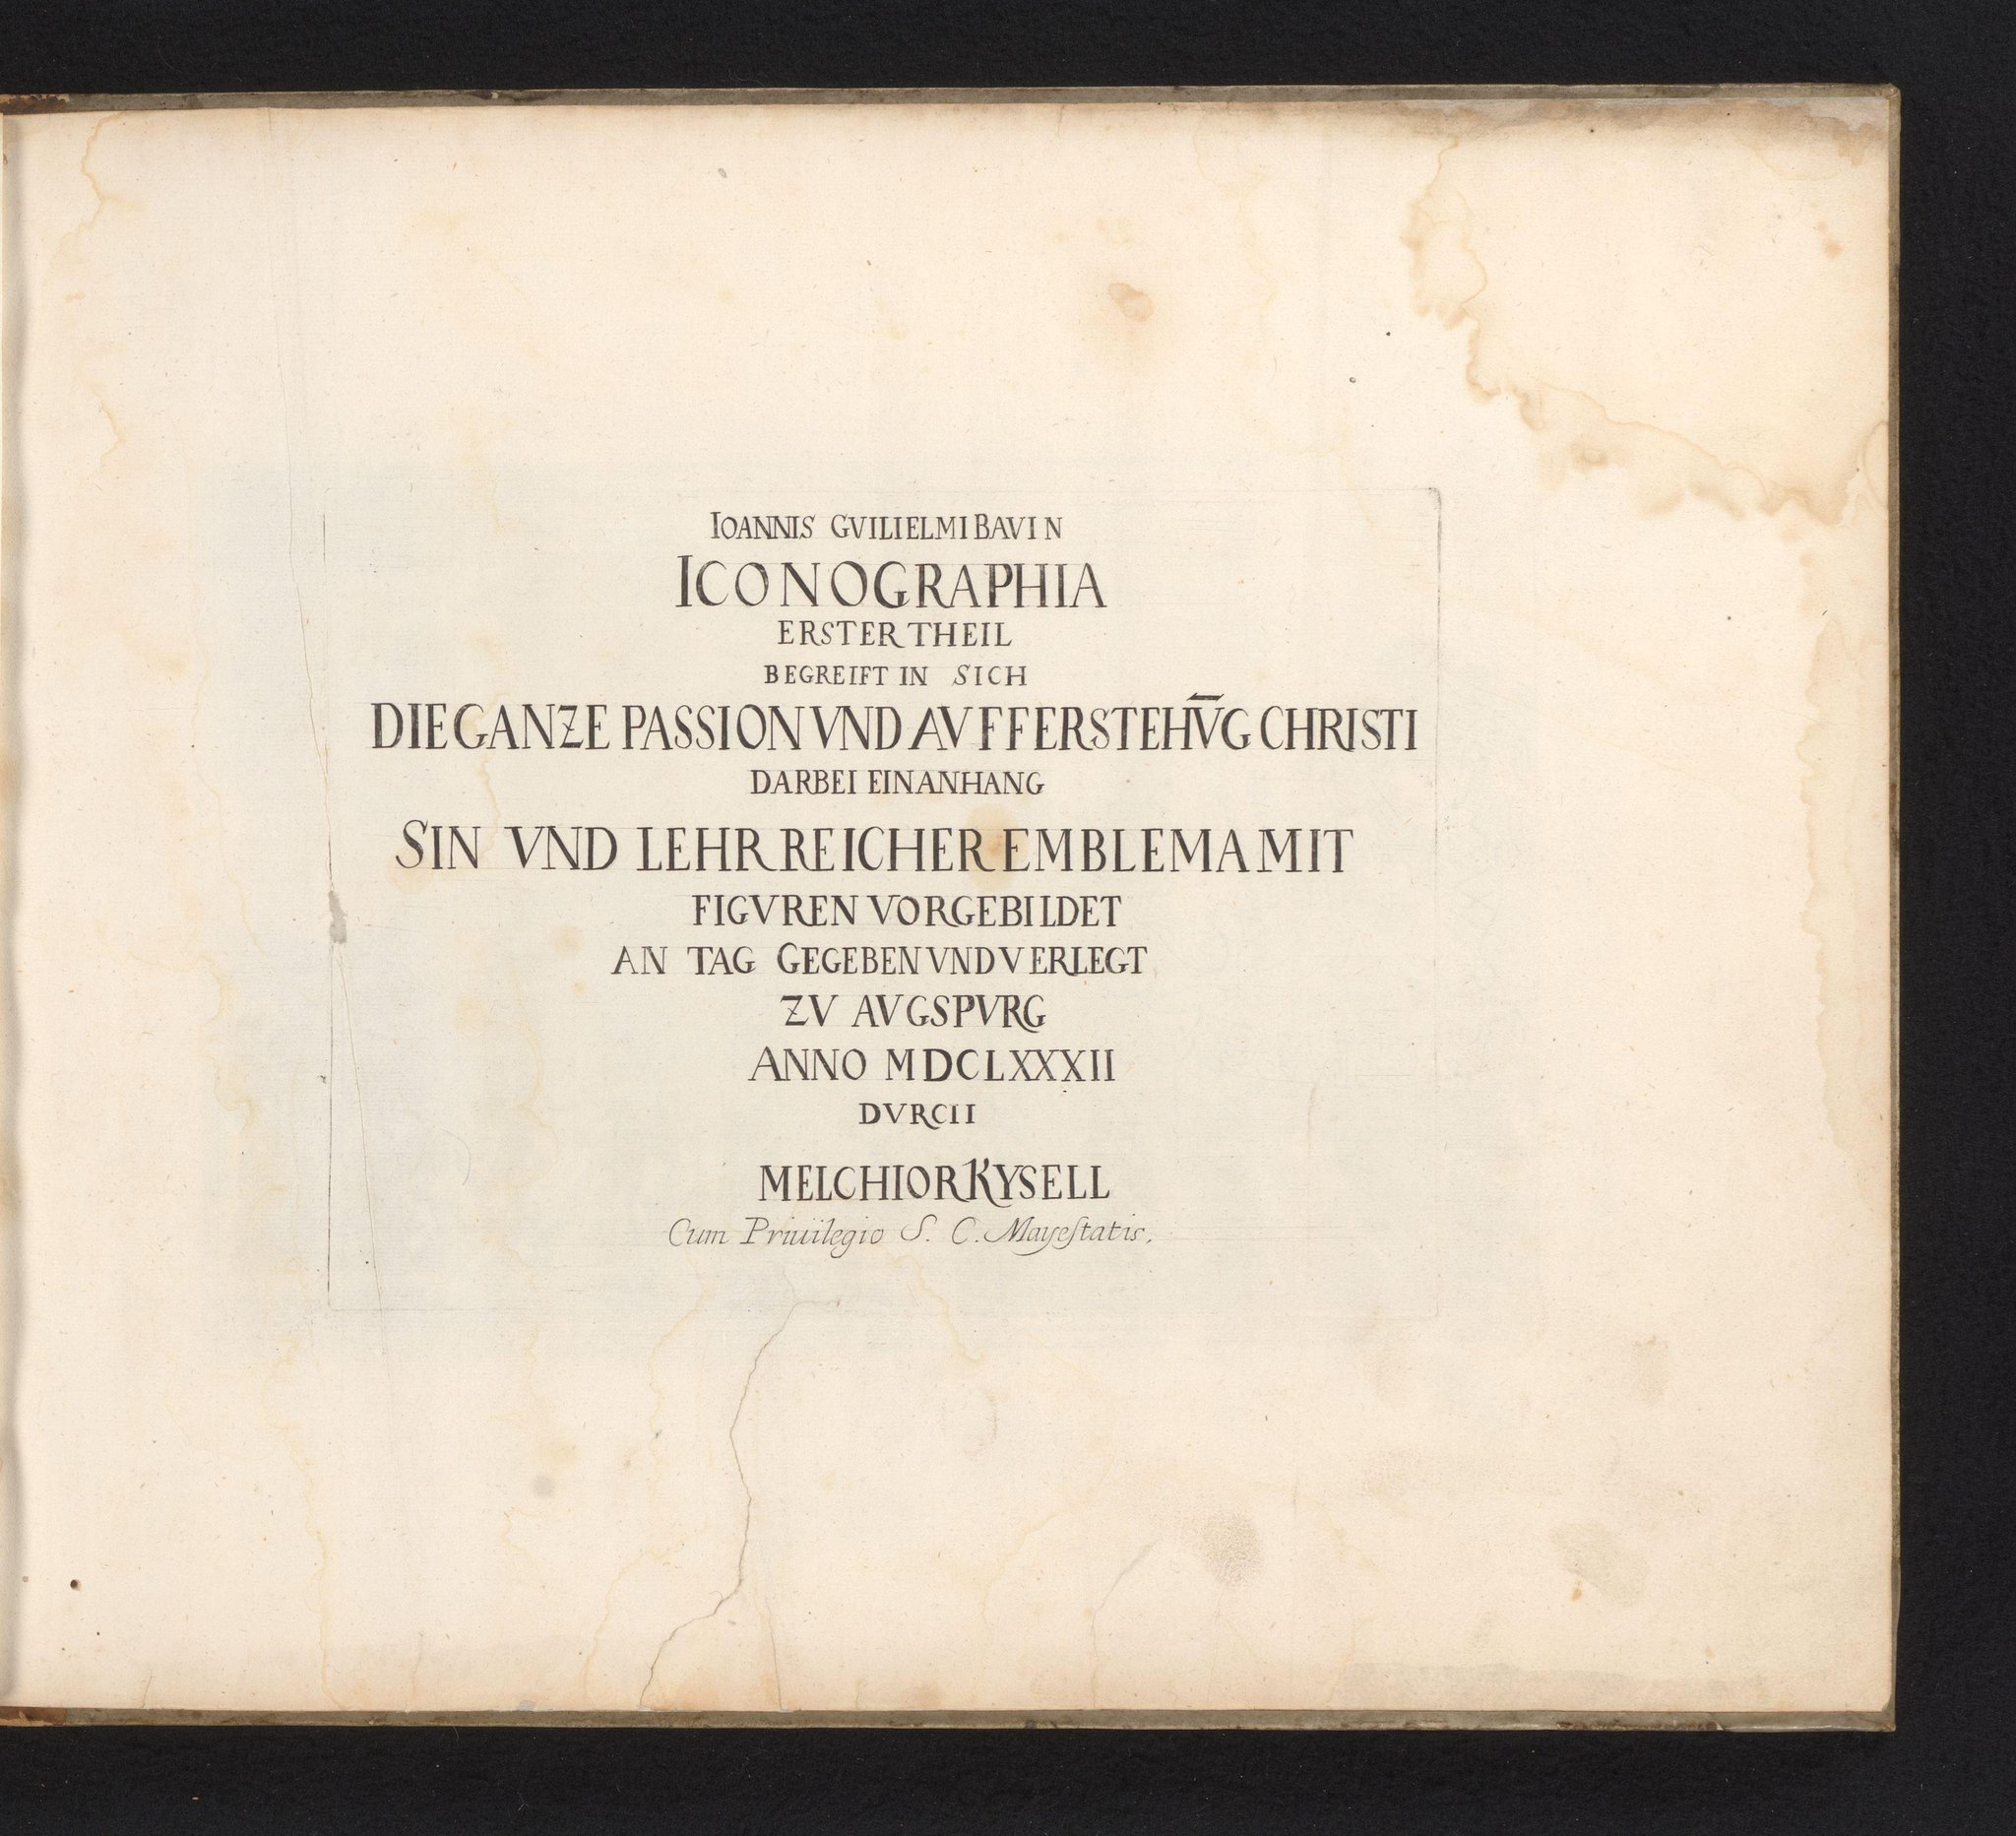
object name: titelprent, frontispice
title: Iconographia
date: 1682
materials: paper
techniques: etching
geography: augsburg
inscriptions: collector's mark: Lugt 2228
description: De volledige titel van het eerste deel luidt: Ioannes Guilielmi Baurn Iconographia Erster Theil, Begreift in sich die Ganze Passion und Aufferstehug Christi darbei Einanhang Sin und Lehr Reicher Emblema mit Figuren Vorgebildet an Tag gegeben und verlegt zu Augspurg anno MDCLXXXII durch Melchior Kysell, Cum Privilegio S.C. Mayestatis.